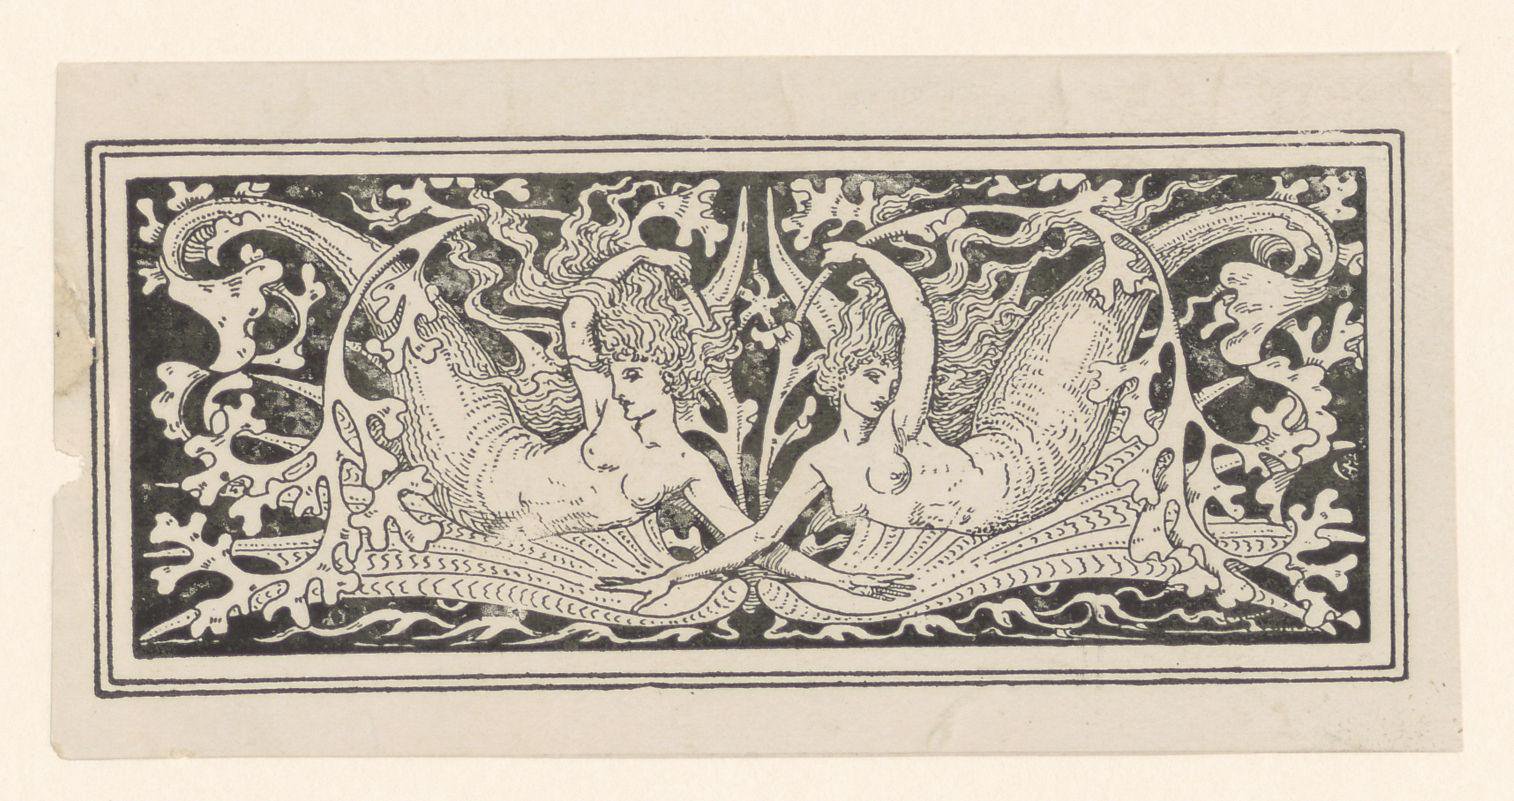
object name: print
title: Twee zeemeerminnen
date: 1887-1893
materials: paper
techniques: engraving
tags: merman - aa - mermaid, siren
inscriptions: collector's mark: Lugt 2228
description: De prent is gebruikt in: Crane, Walter. The claims of decorative art. Londen: Lawrence & Bullen, 1892.